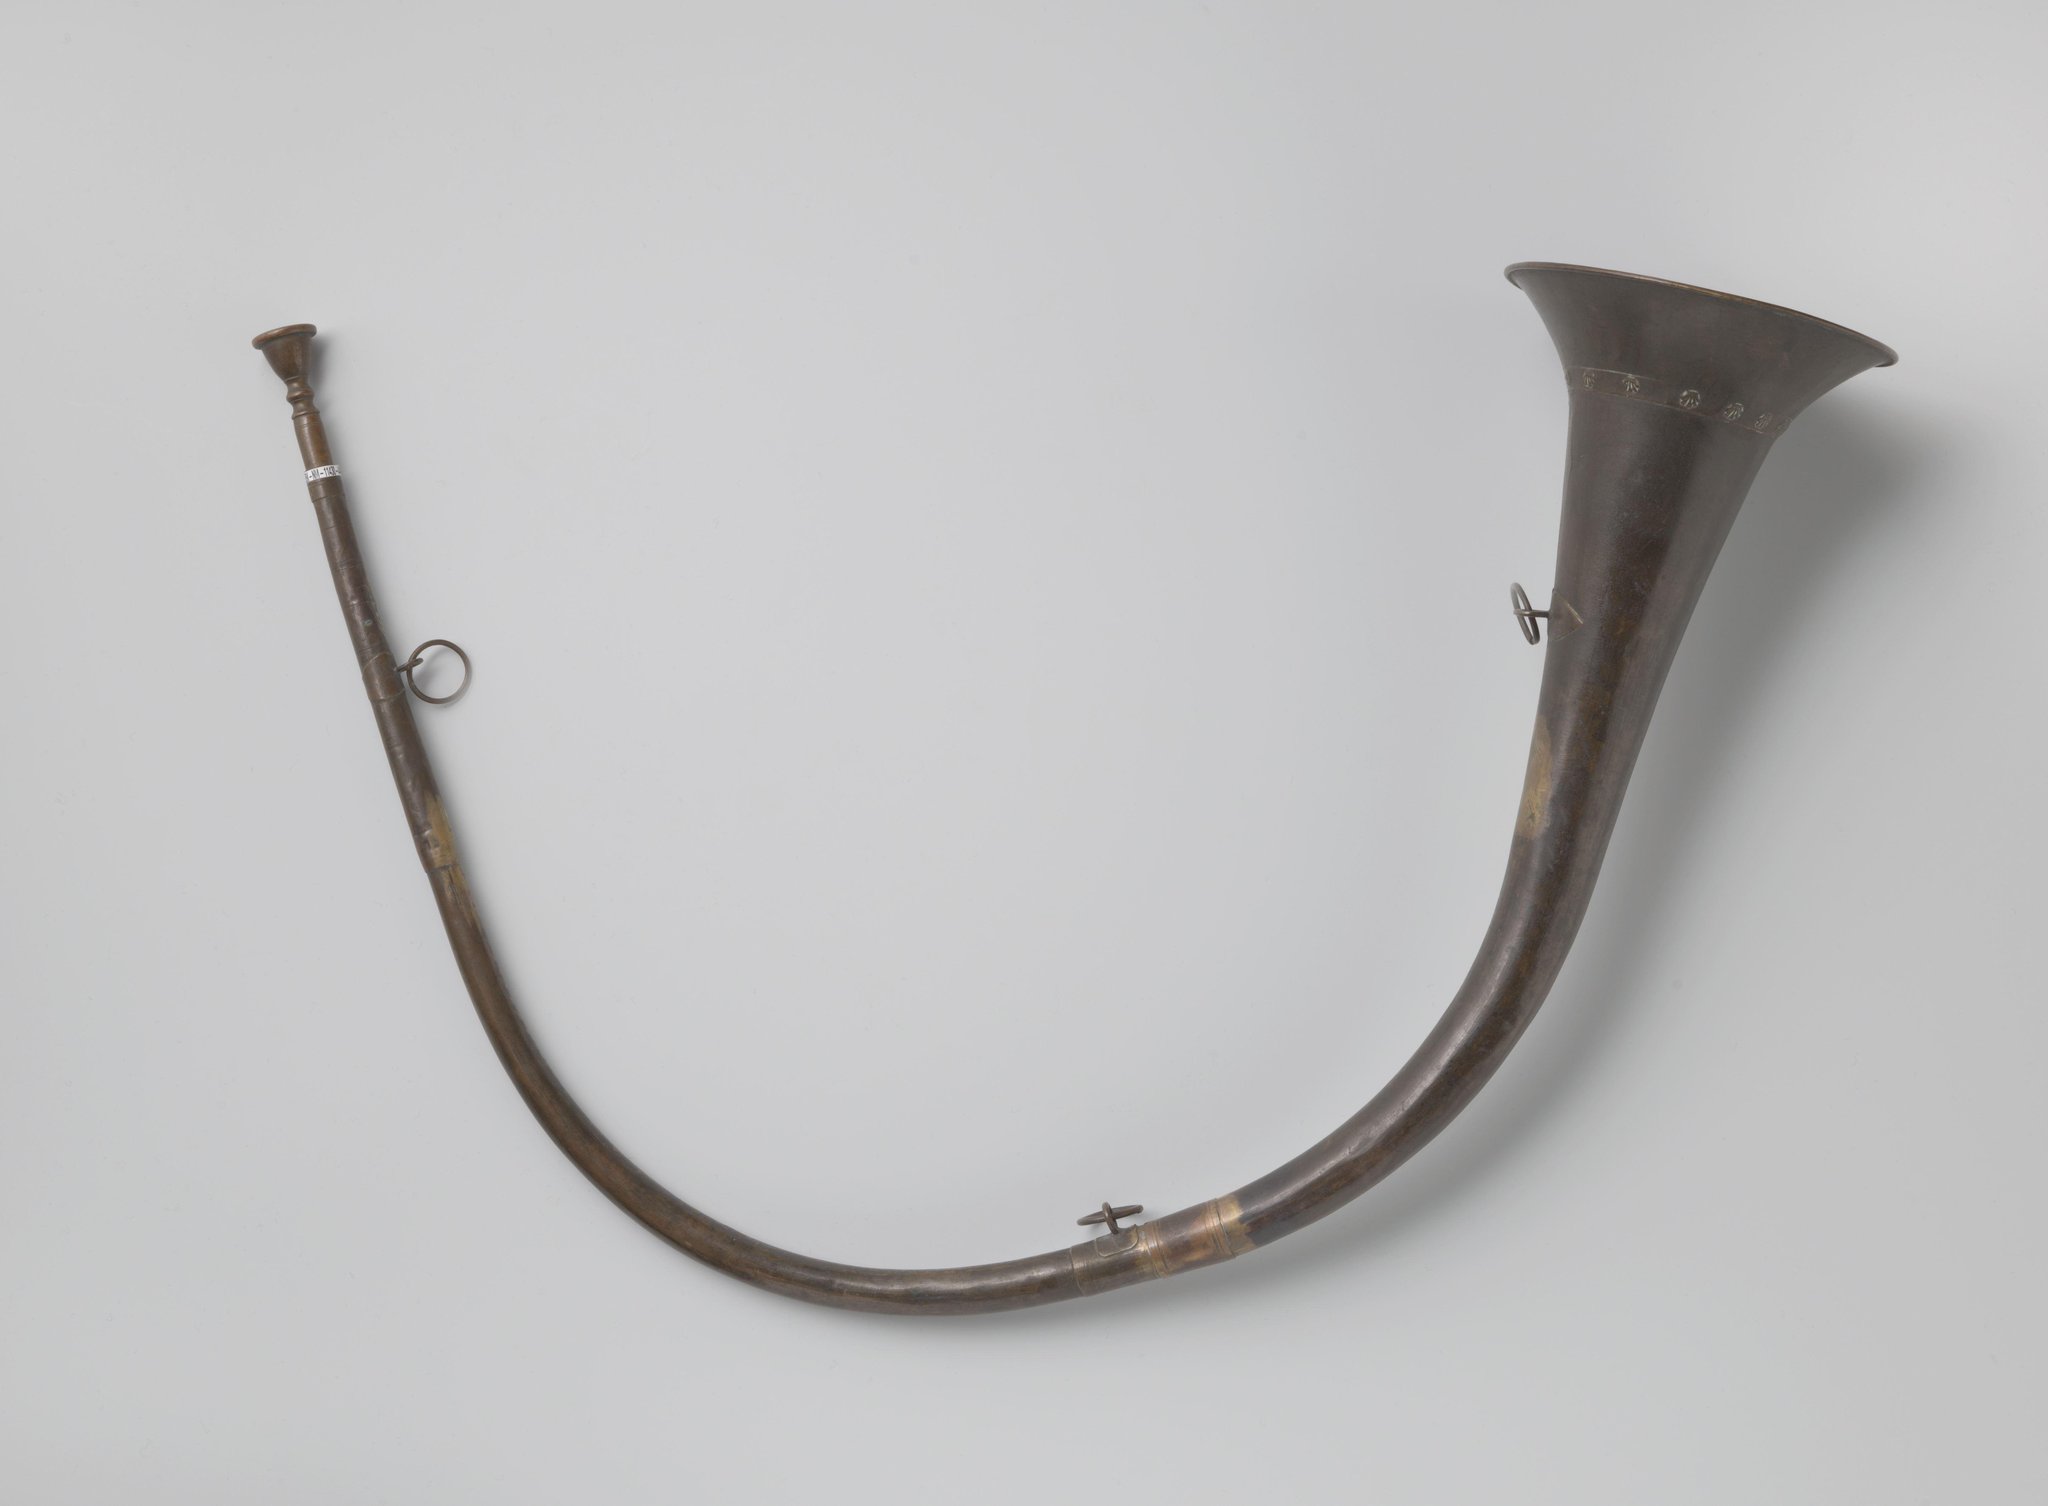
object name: wind instrument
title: Half-moon-shaped bugle (halbmond)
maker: Anonymous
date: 1800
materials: copper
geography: germany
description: Jachthoorn (halve maan) in D van messing. Rondom de beker is een krans gelegd, die aan de bovenzijde versierd is met een rand schelpmotiven en relief. In het midden en aan de beide uiteinden zijn ringen bevestigd voor een draagriem.